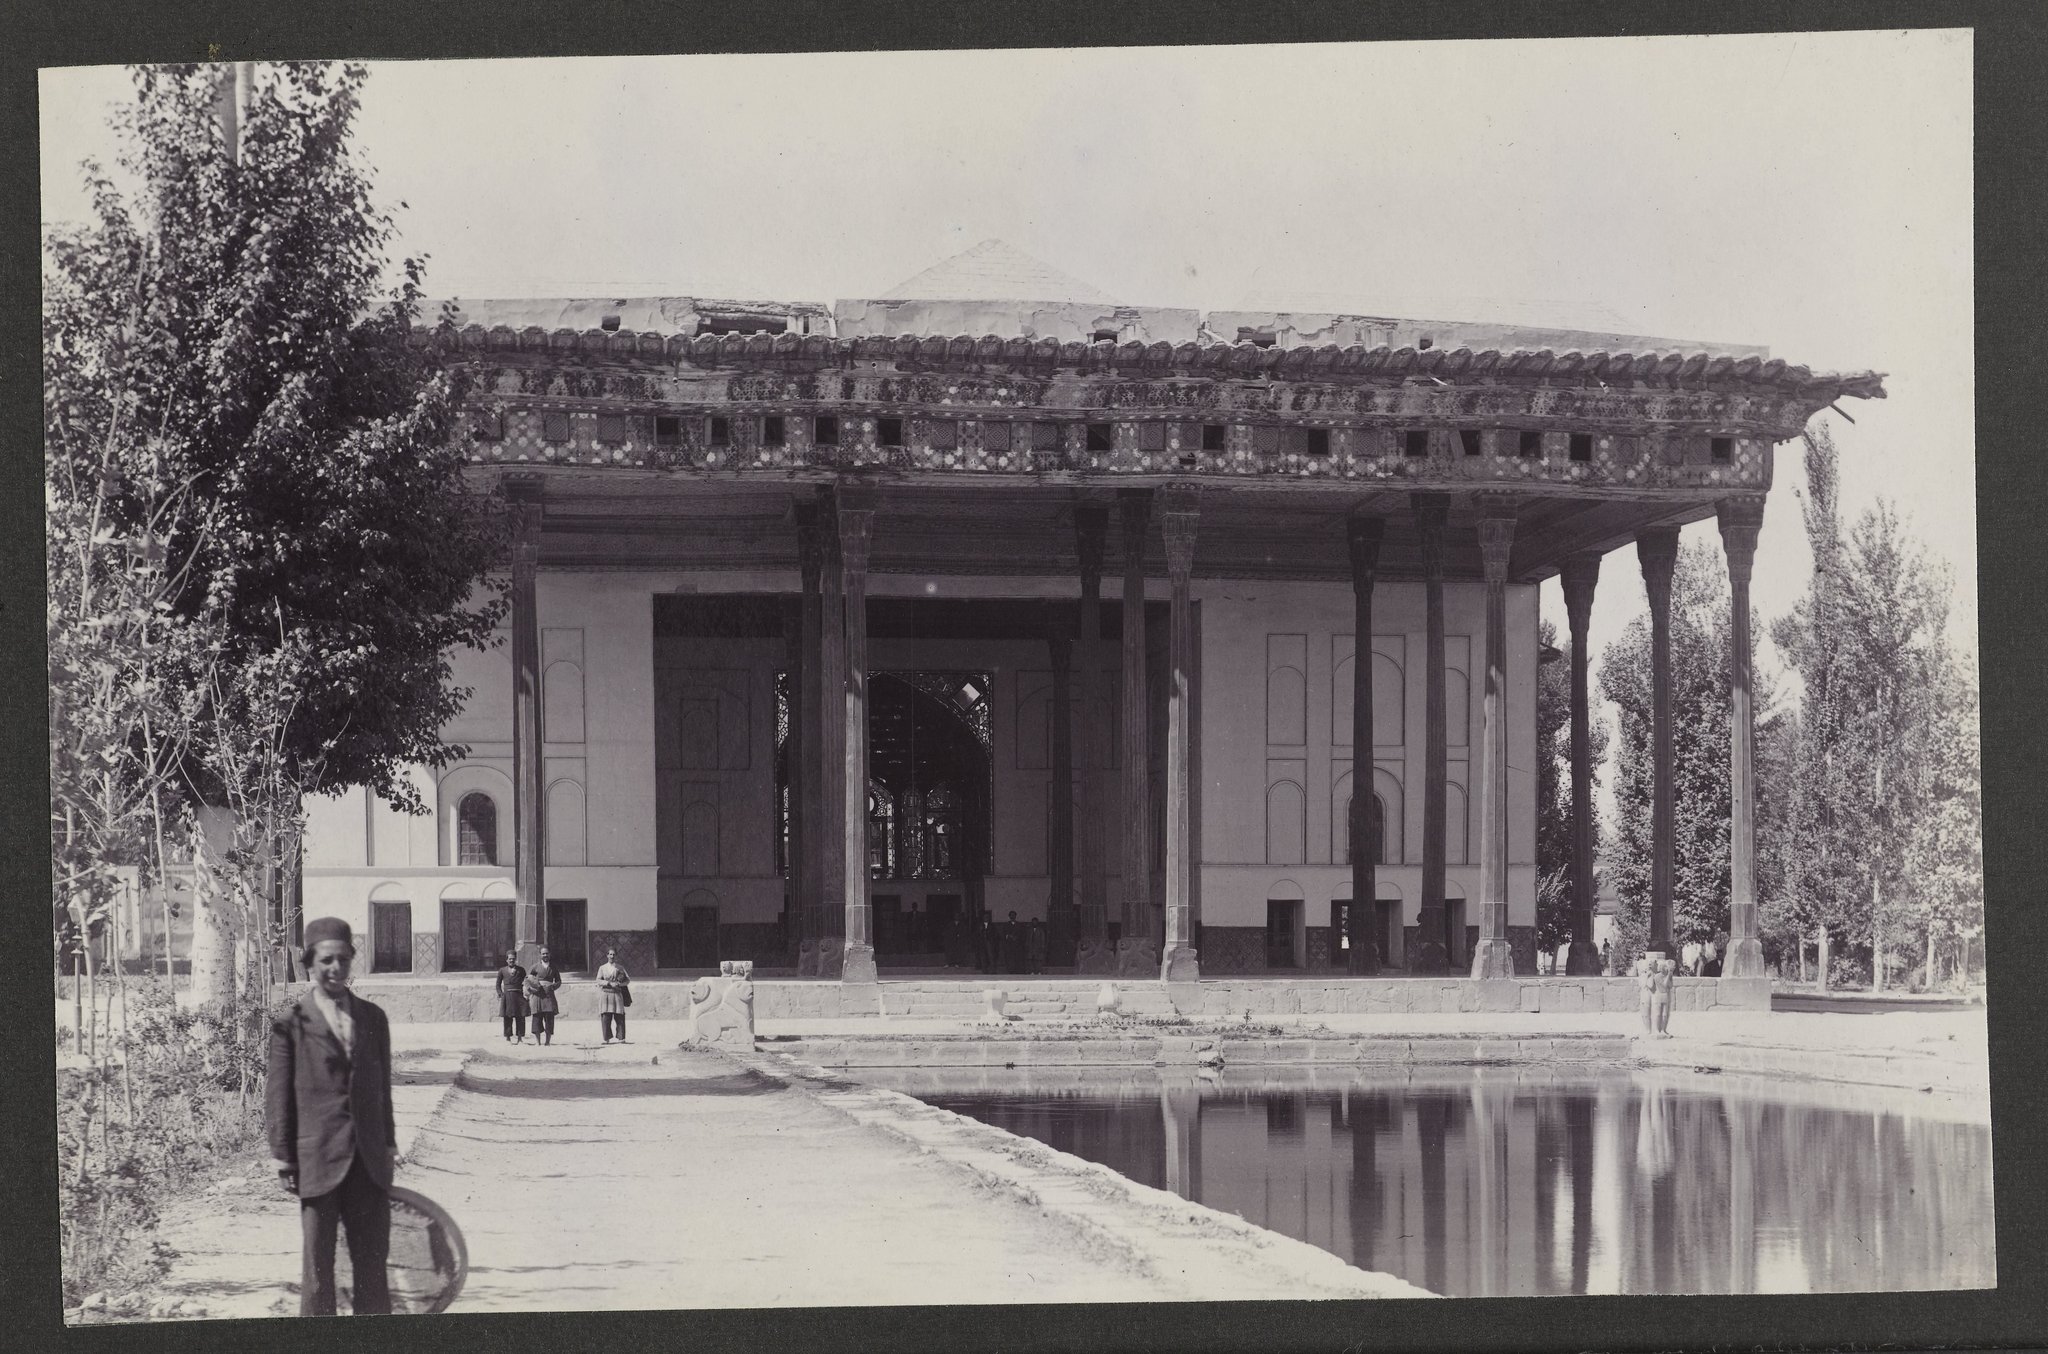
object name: photograph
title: Groot gebouw met vijver, Perzië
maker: a.g.a. van eelde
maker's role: engineer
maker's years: 1862-1950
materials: cardboard, paper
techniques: gelatin silver print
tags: iran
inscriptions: number: ‘48.’